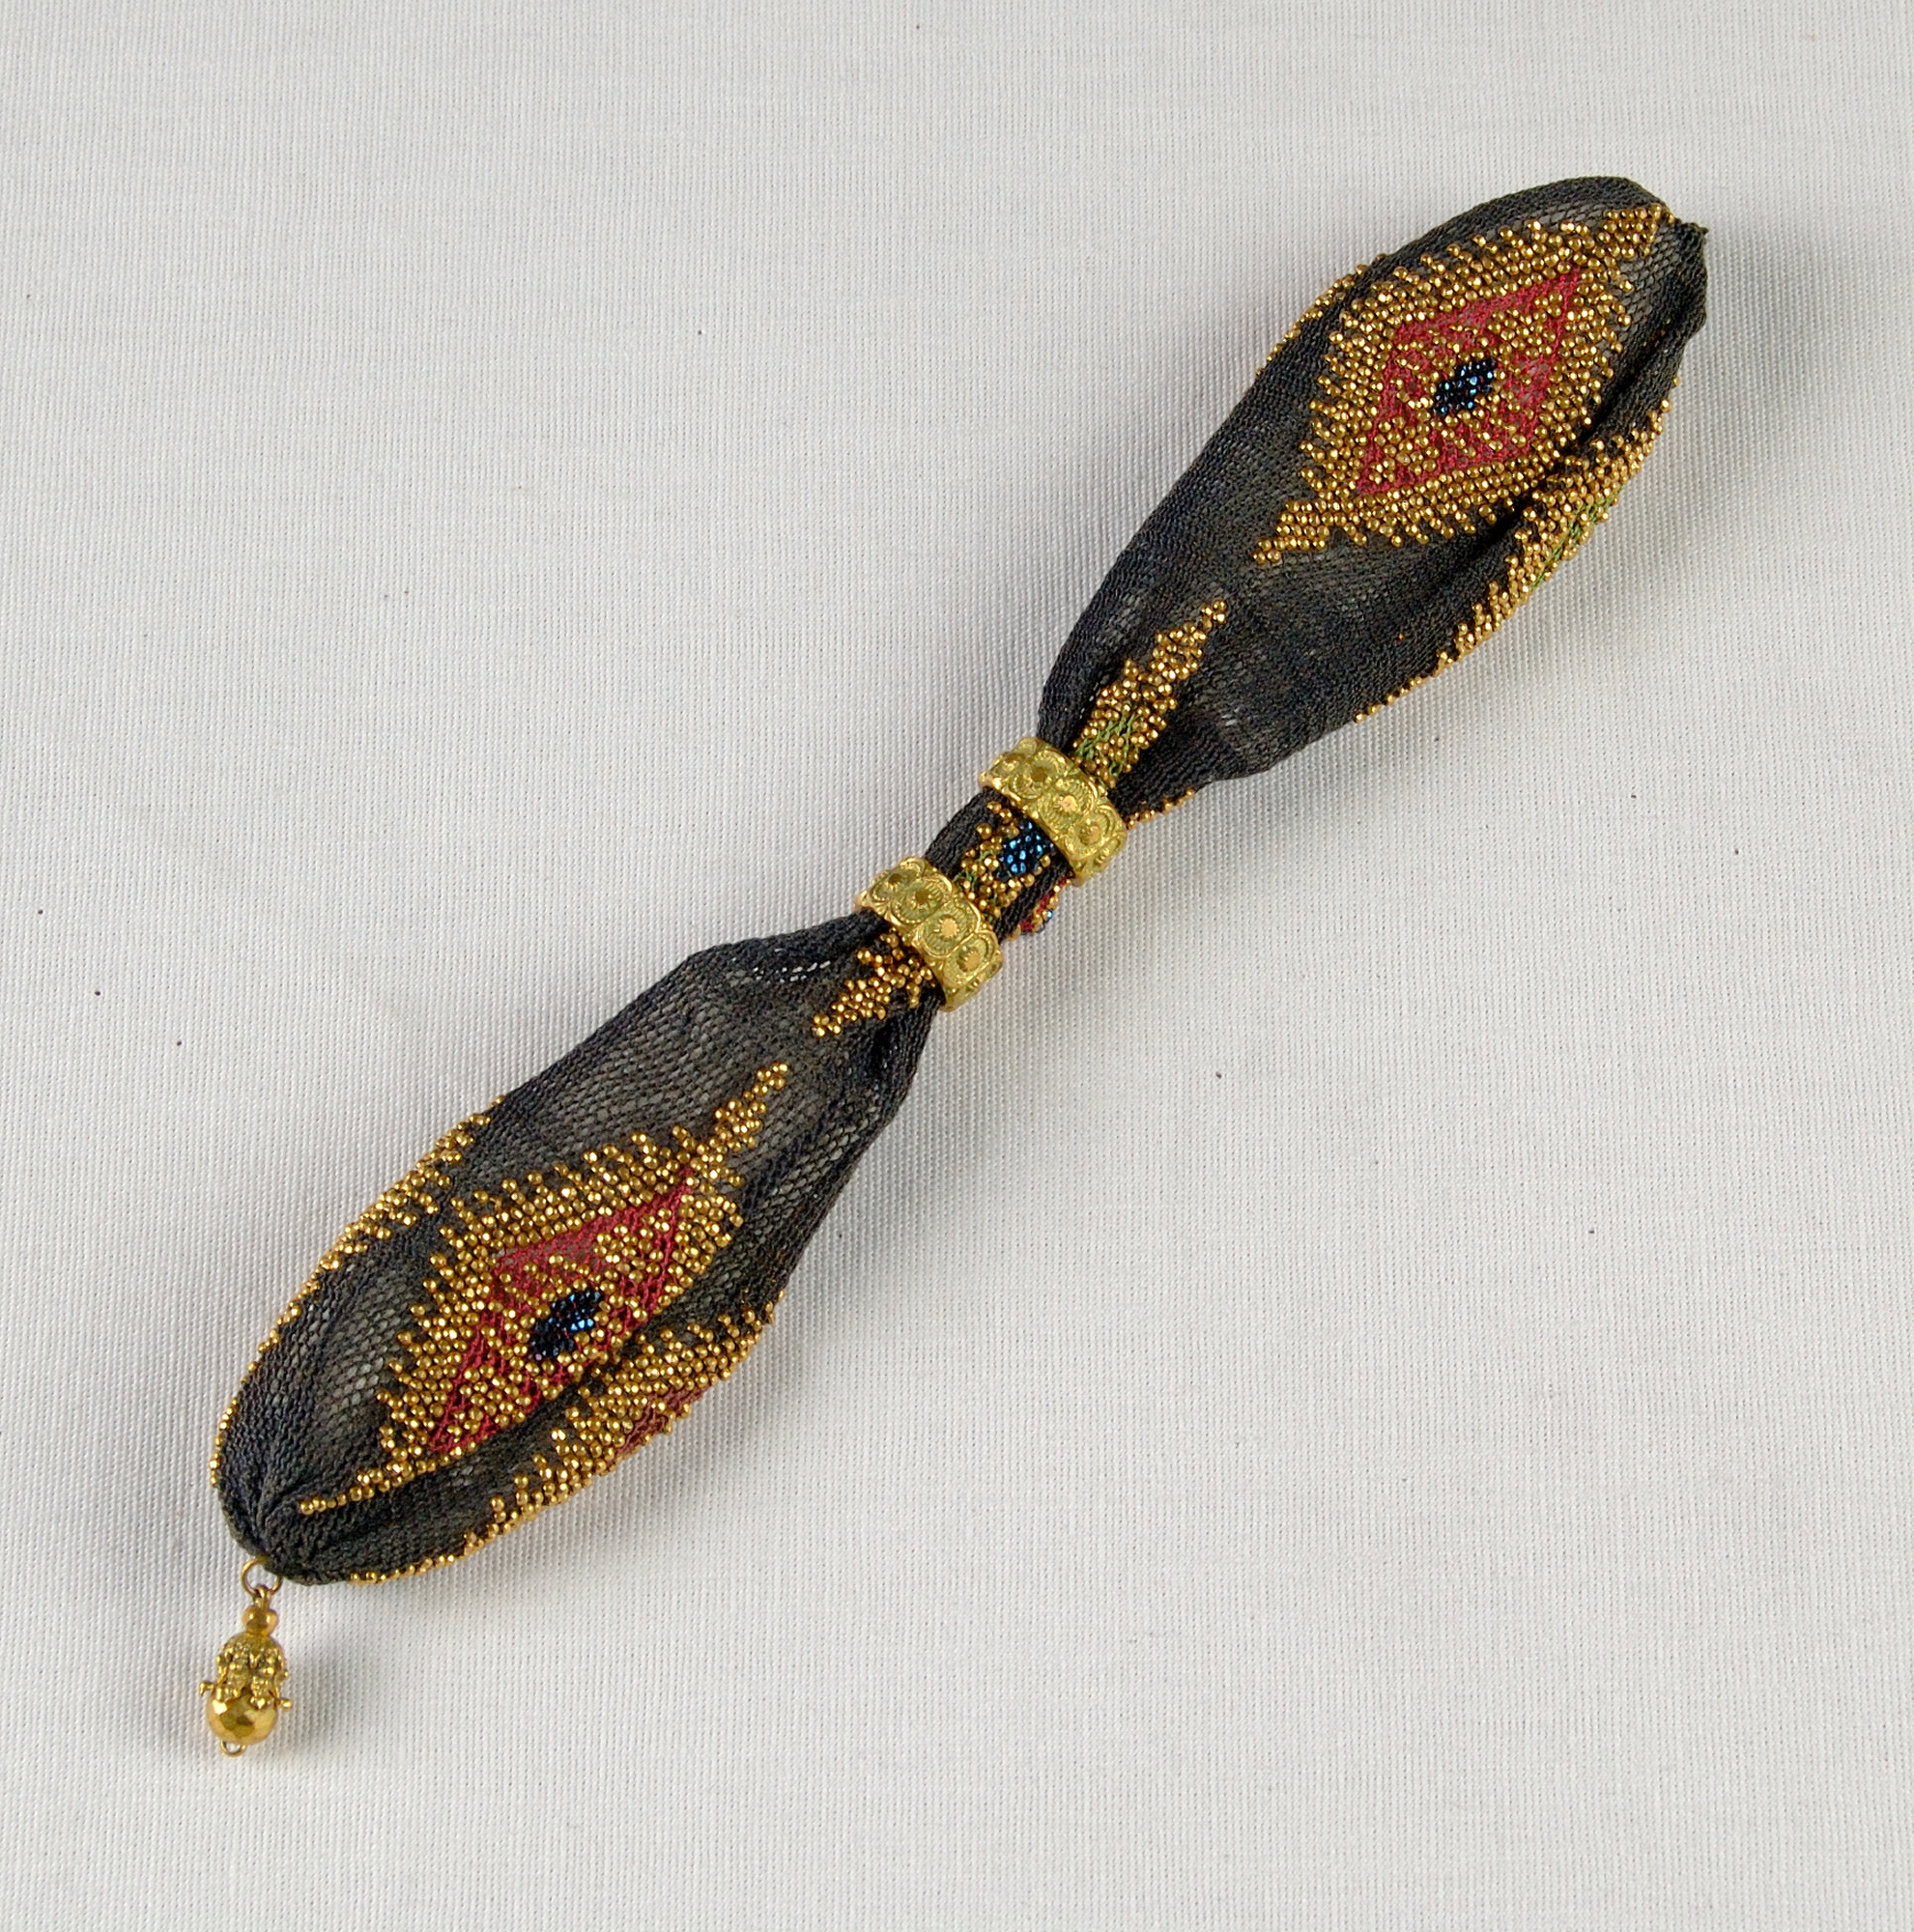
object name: miser's purse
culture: american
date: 1867-1900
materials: metal, silk